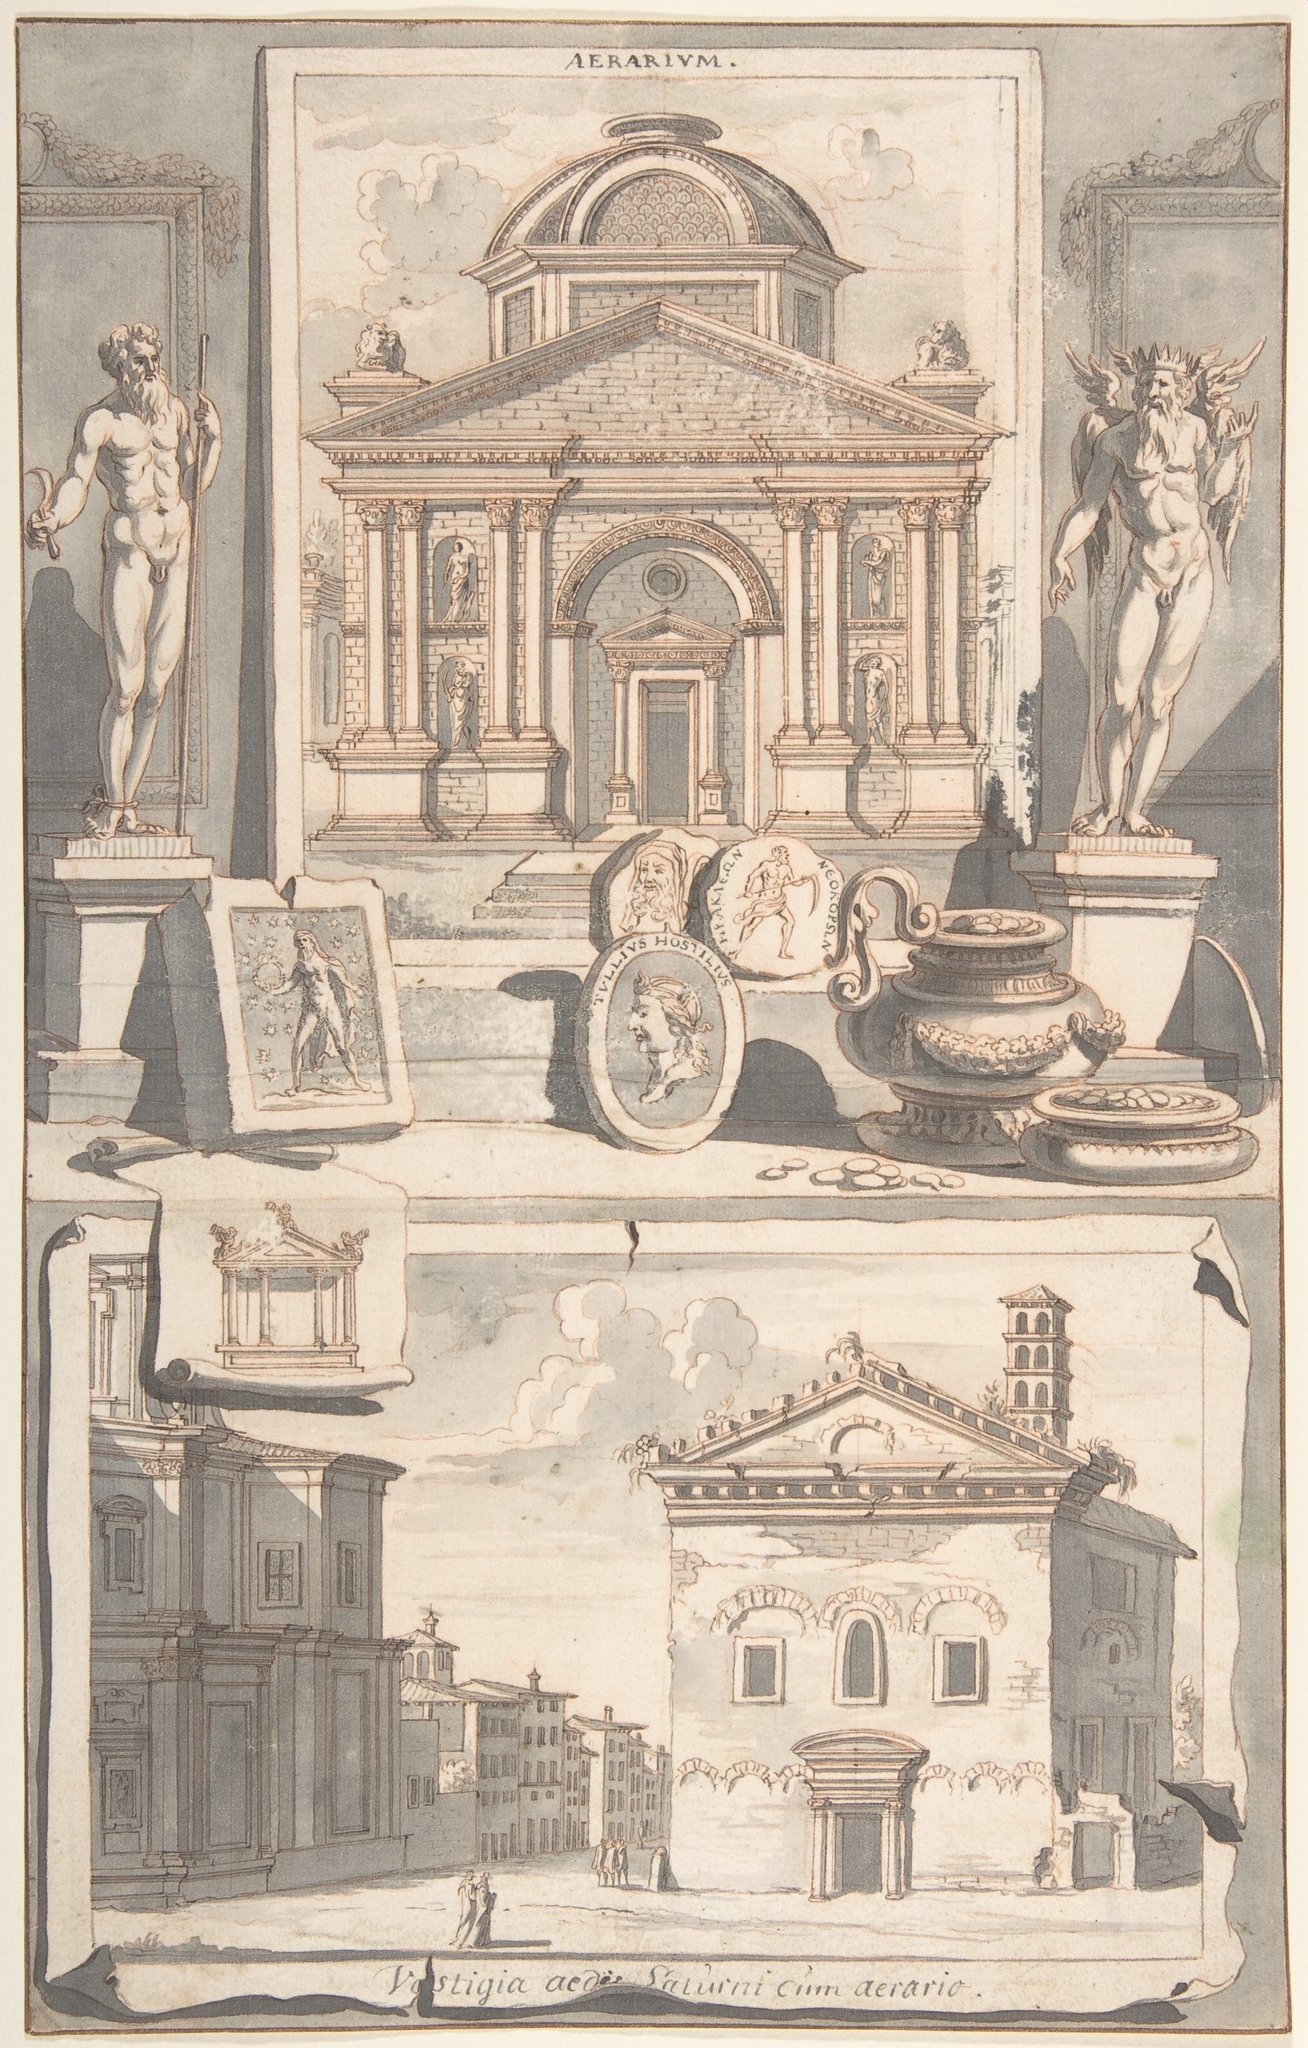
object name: drawing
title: A Reconstruction of the Aerarium (above) and a View of the Ruins (below)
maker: jan goeree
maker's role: artist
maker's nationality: dutch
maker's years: 1670-1731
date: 1704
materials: chalk, ink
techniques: brush, pen, wash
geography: italy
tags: buildings,ruins,male nudes